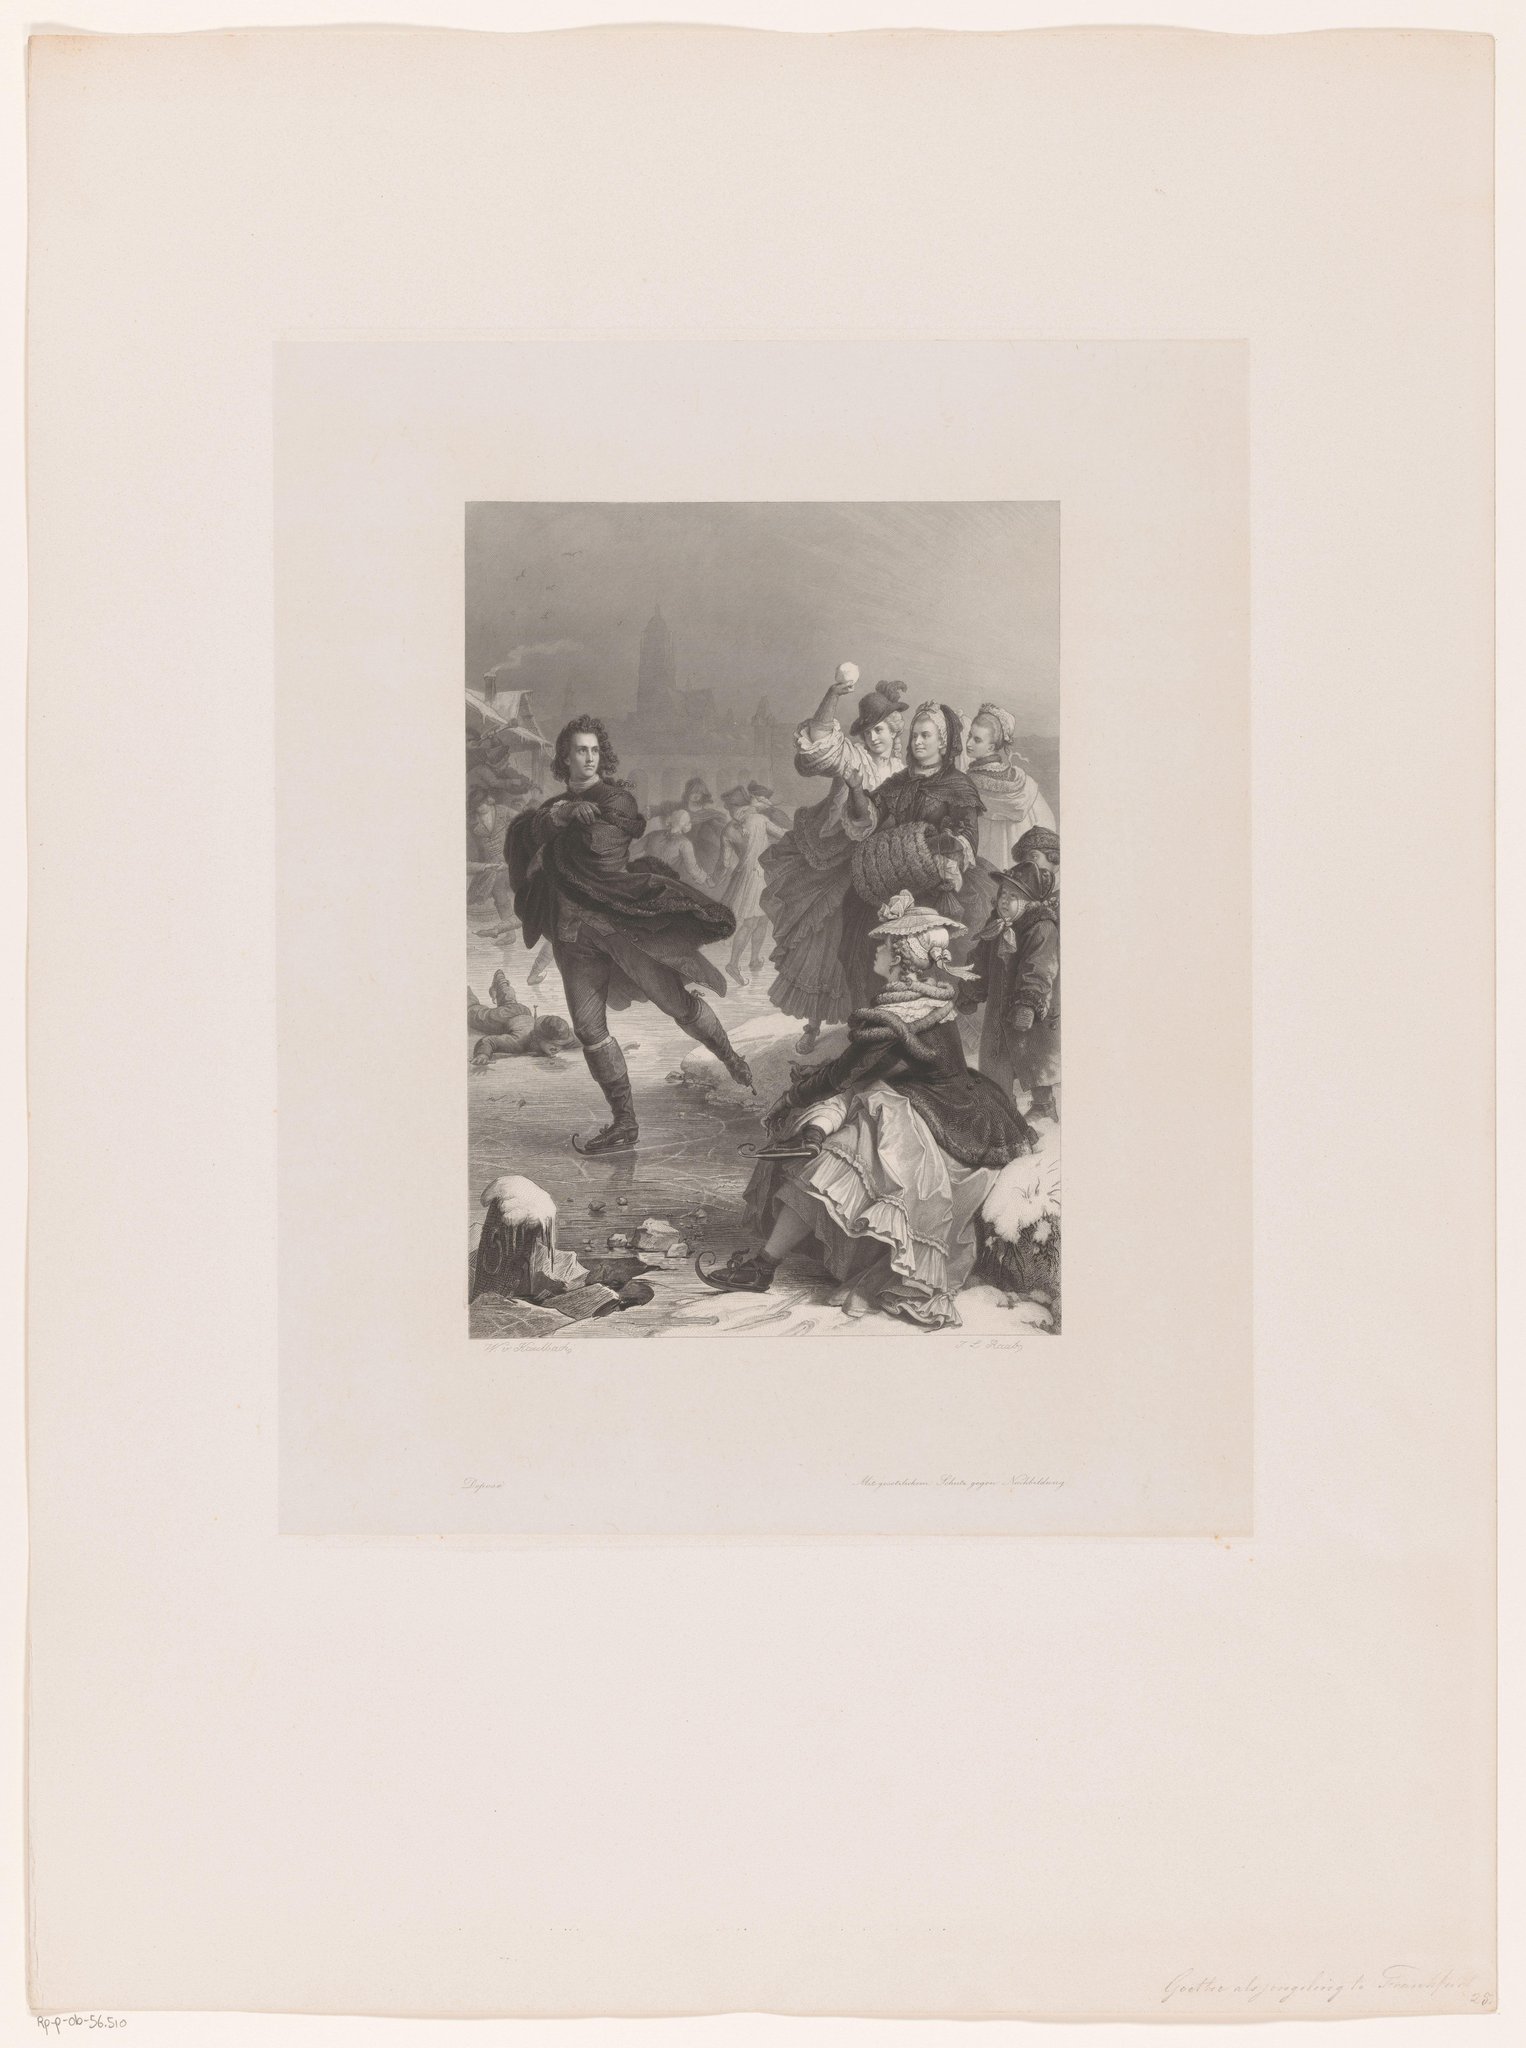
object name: print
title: Jongeman schaatst langs een groep dames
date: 1864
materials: paper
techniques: etching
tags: throwing snowballs - cc - adult(s) ~ snow and ice, skates (winter sports)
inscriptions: : ‘Deposé’, collector's mark: Lugt 2228